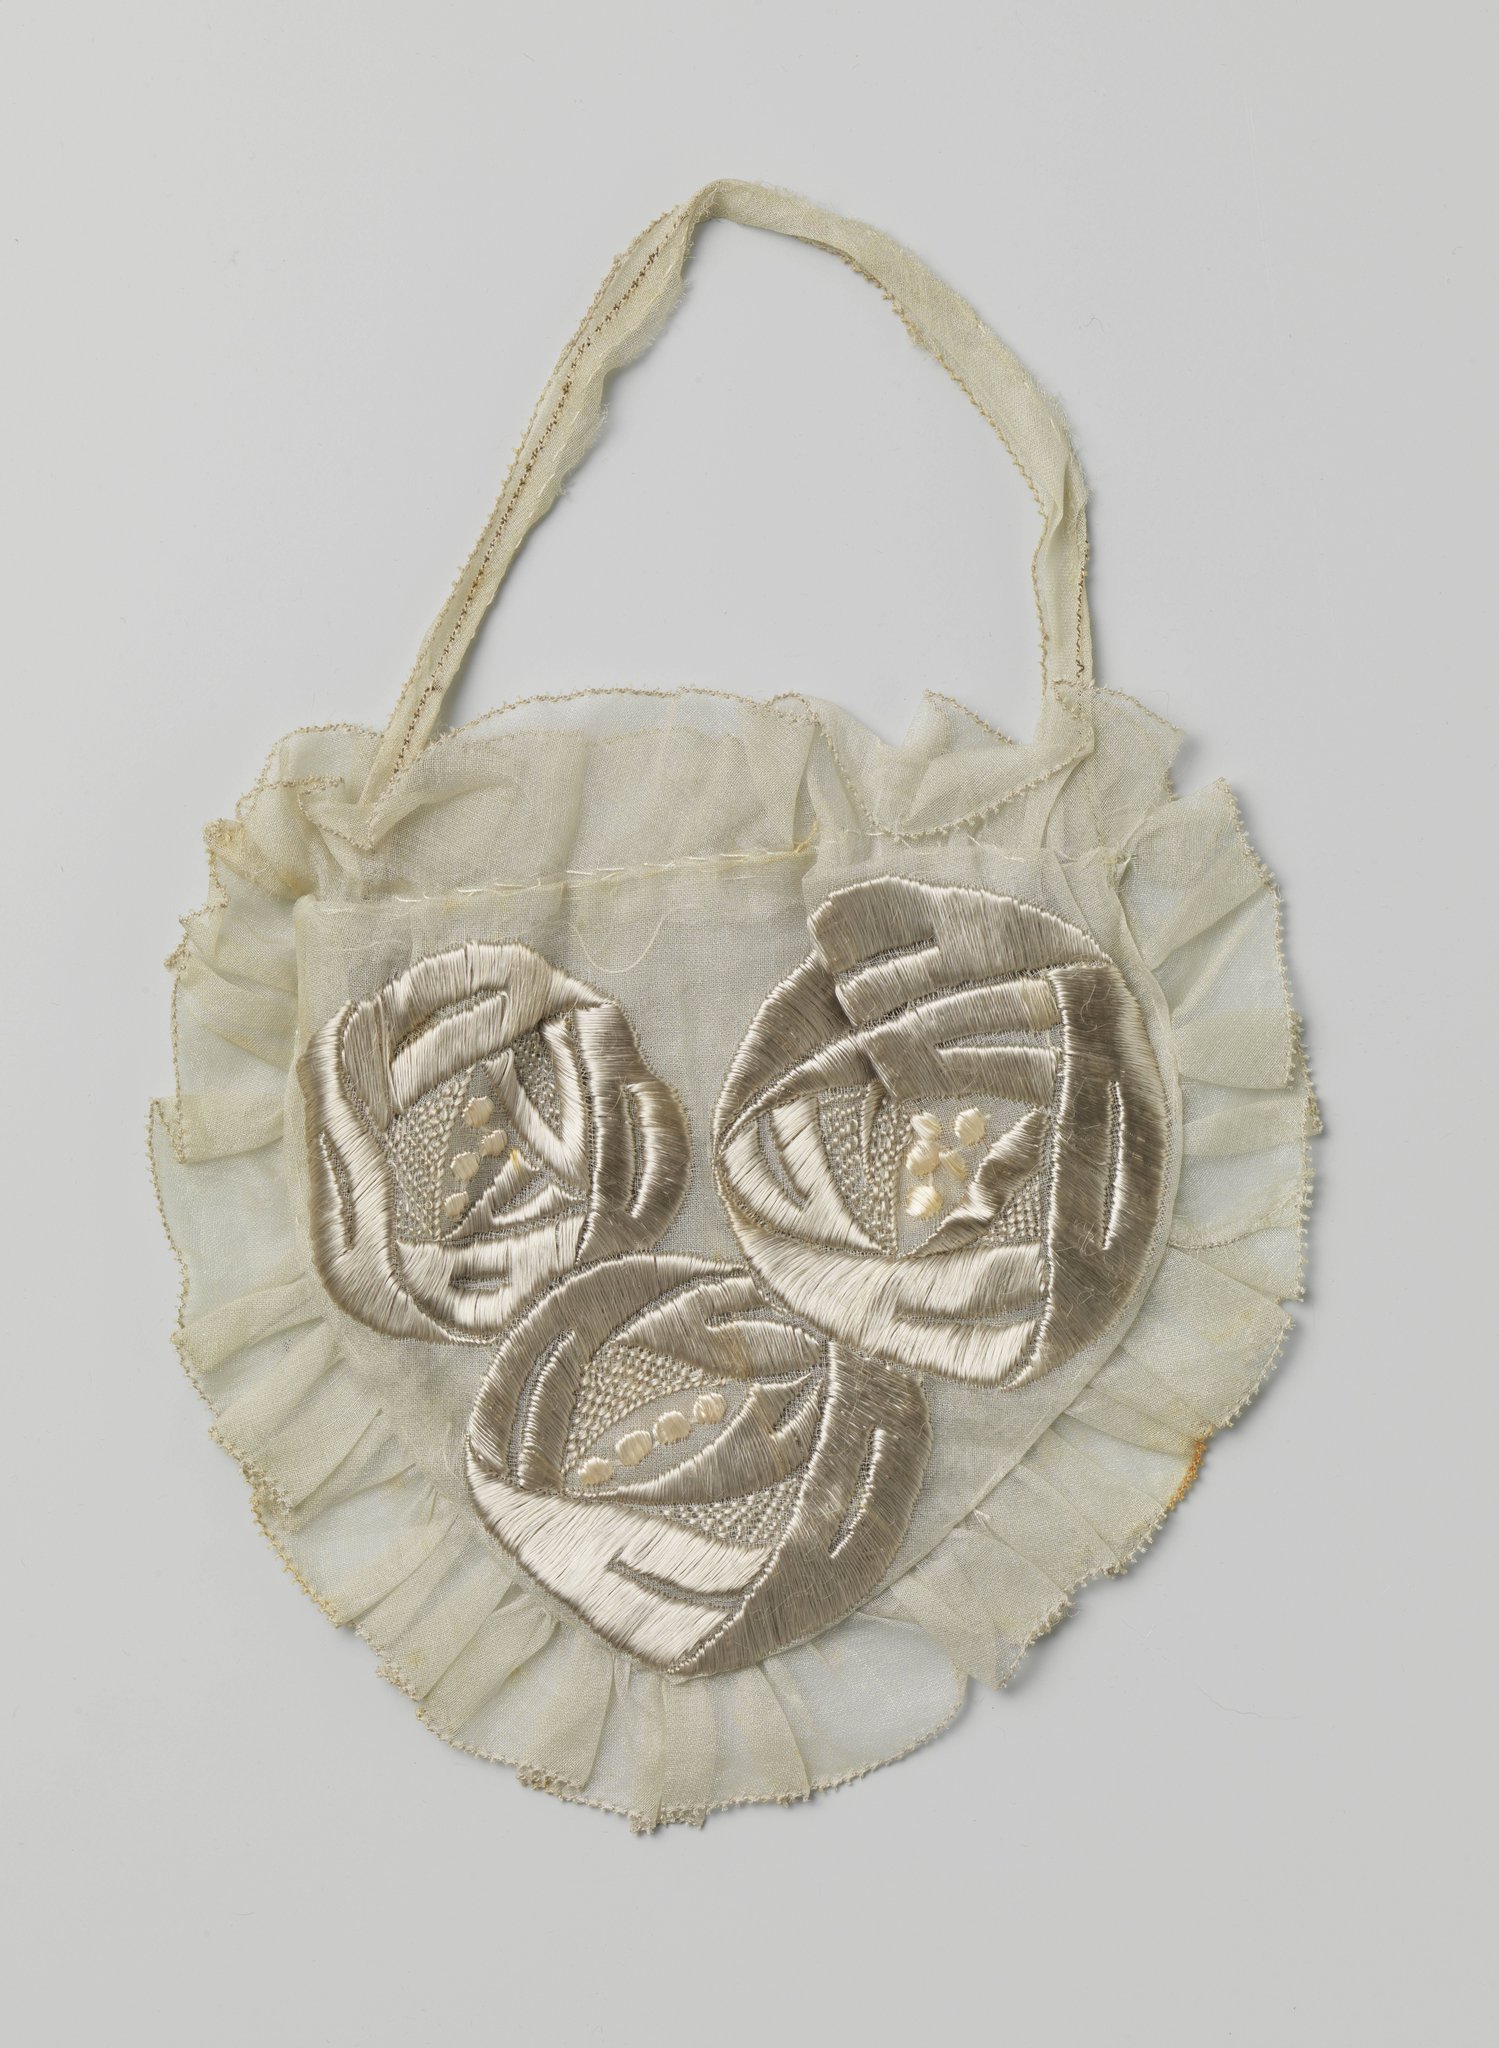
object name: evening bag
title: Avondtasje van glasbatist, met aan weerszijden drie geborduurde zilverkleurige zijden bloemen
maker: Anonymous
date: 1920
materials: silk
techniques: embroidered, weave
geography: netherlands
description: Avondtasje van glasbatist in een schildvorm, waarlangs de gehele rand een geplooide strook. De voor- en achterkant van het tasje zijn geborduurd met drie zilverkleurige bloemen van vloszijd. Het tasje heeft een hengsel van glasbatist en is ook gevoerd met glasbatist.